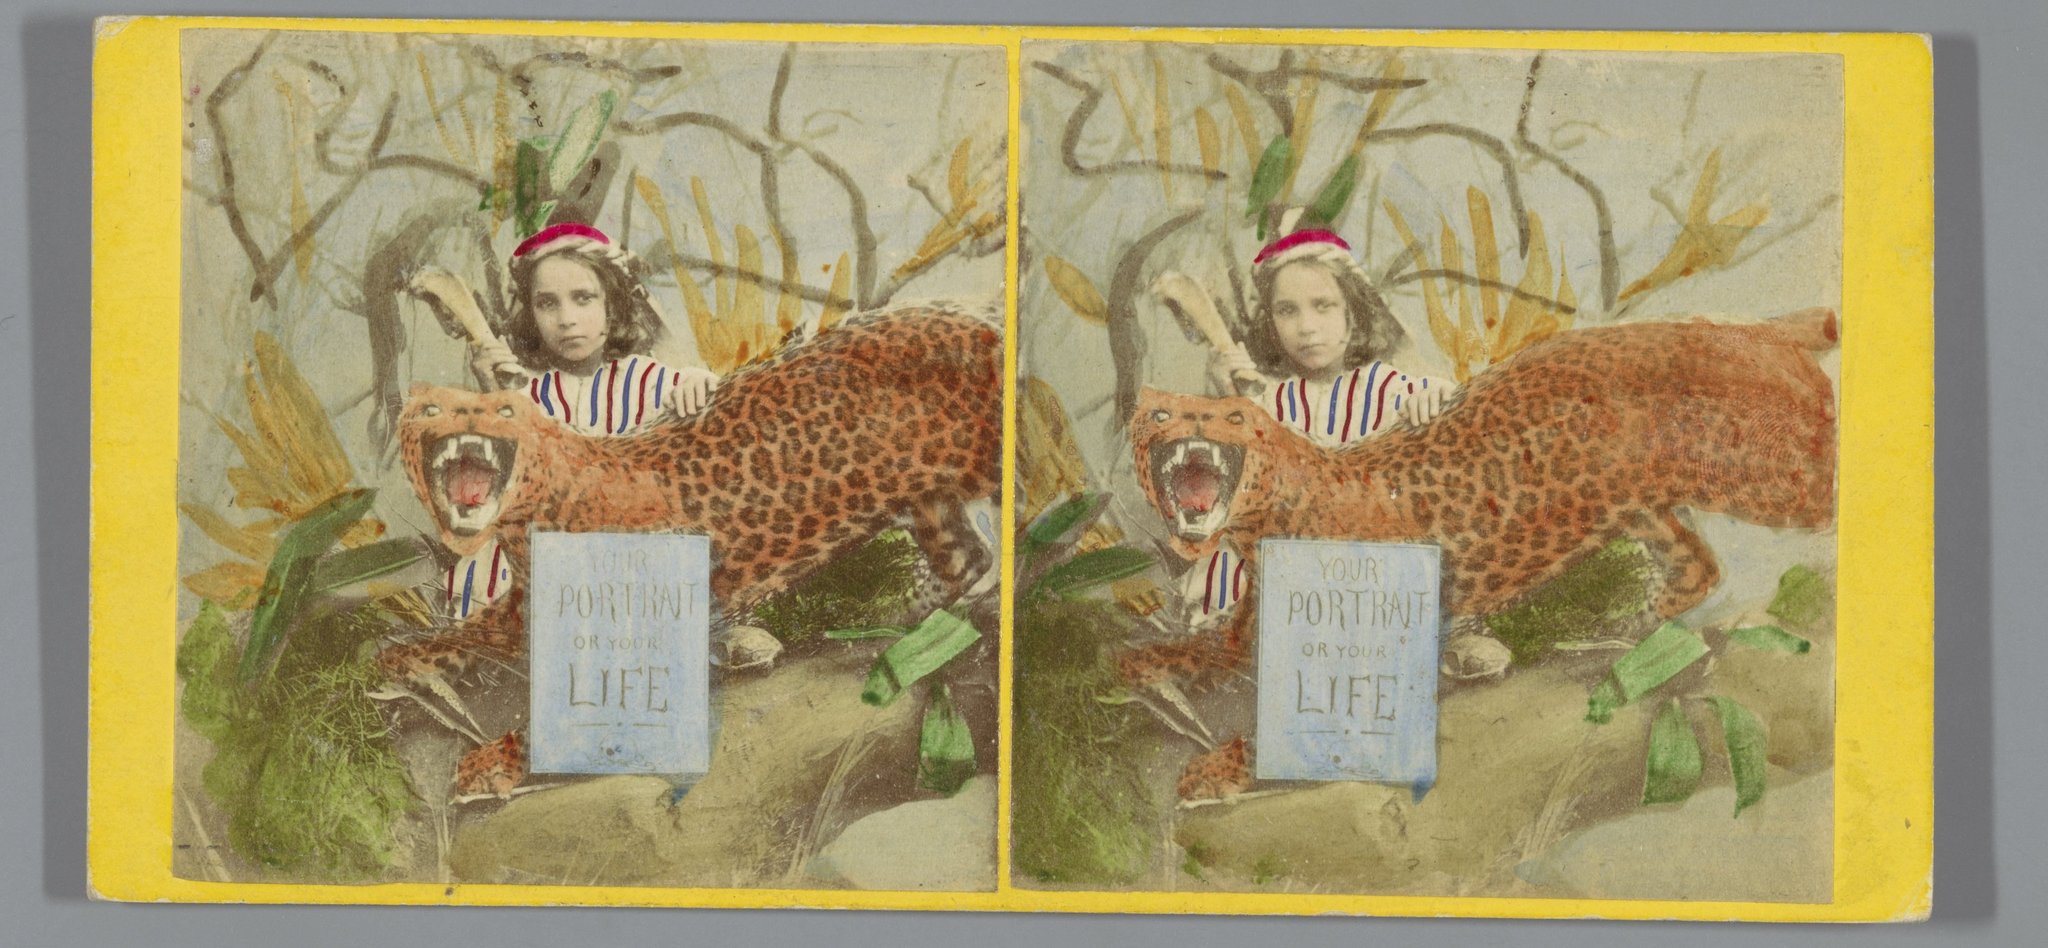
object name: stereograph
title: Your Portrait or your Life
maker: Anonymous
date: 1858-1870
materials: cardboard, paper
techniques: albumen print, hand coloring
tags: beasts of prey, predatory animals: tiger, girl (child between toddler and youth)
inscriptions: inscription: ‘2.50’